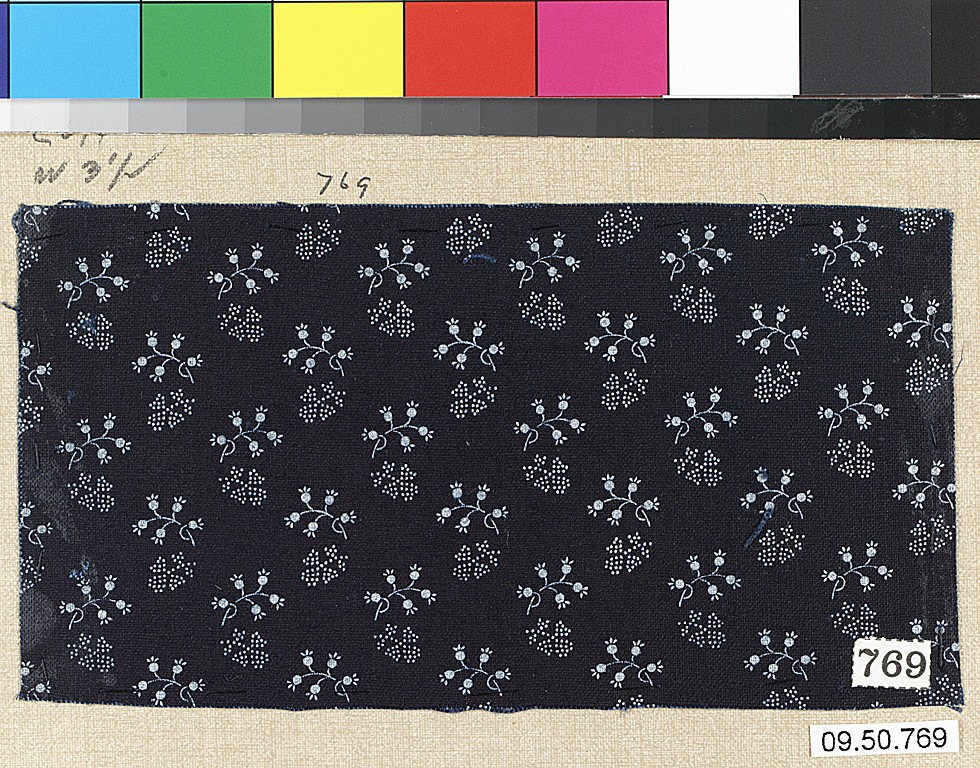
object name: piece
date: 1801-1900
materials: cotton